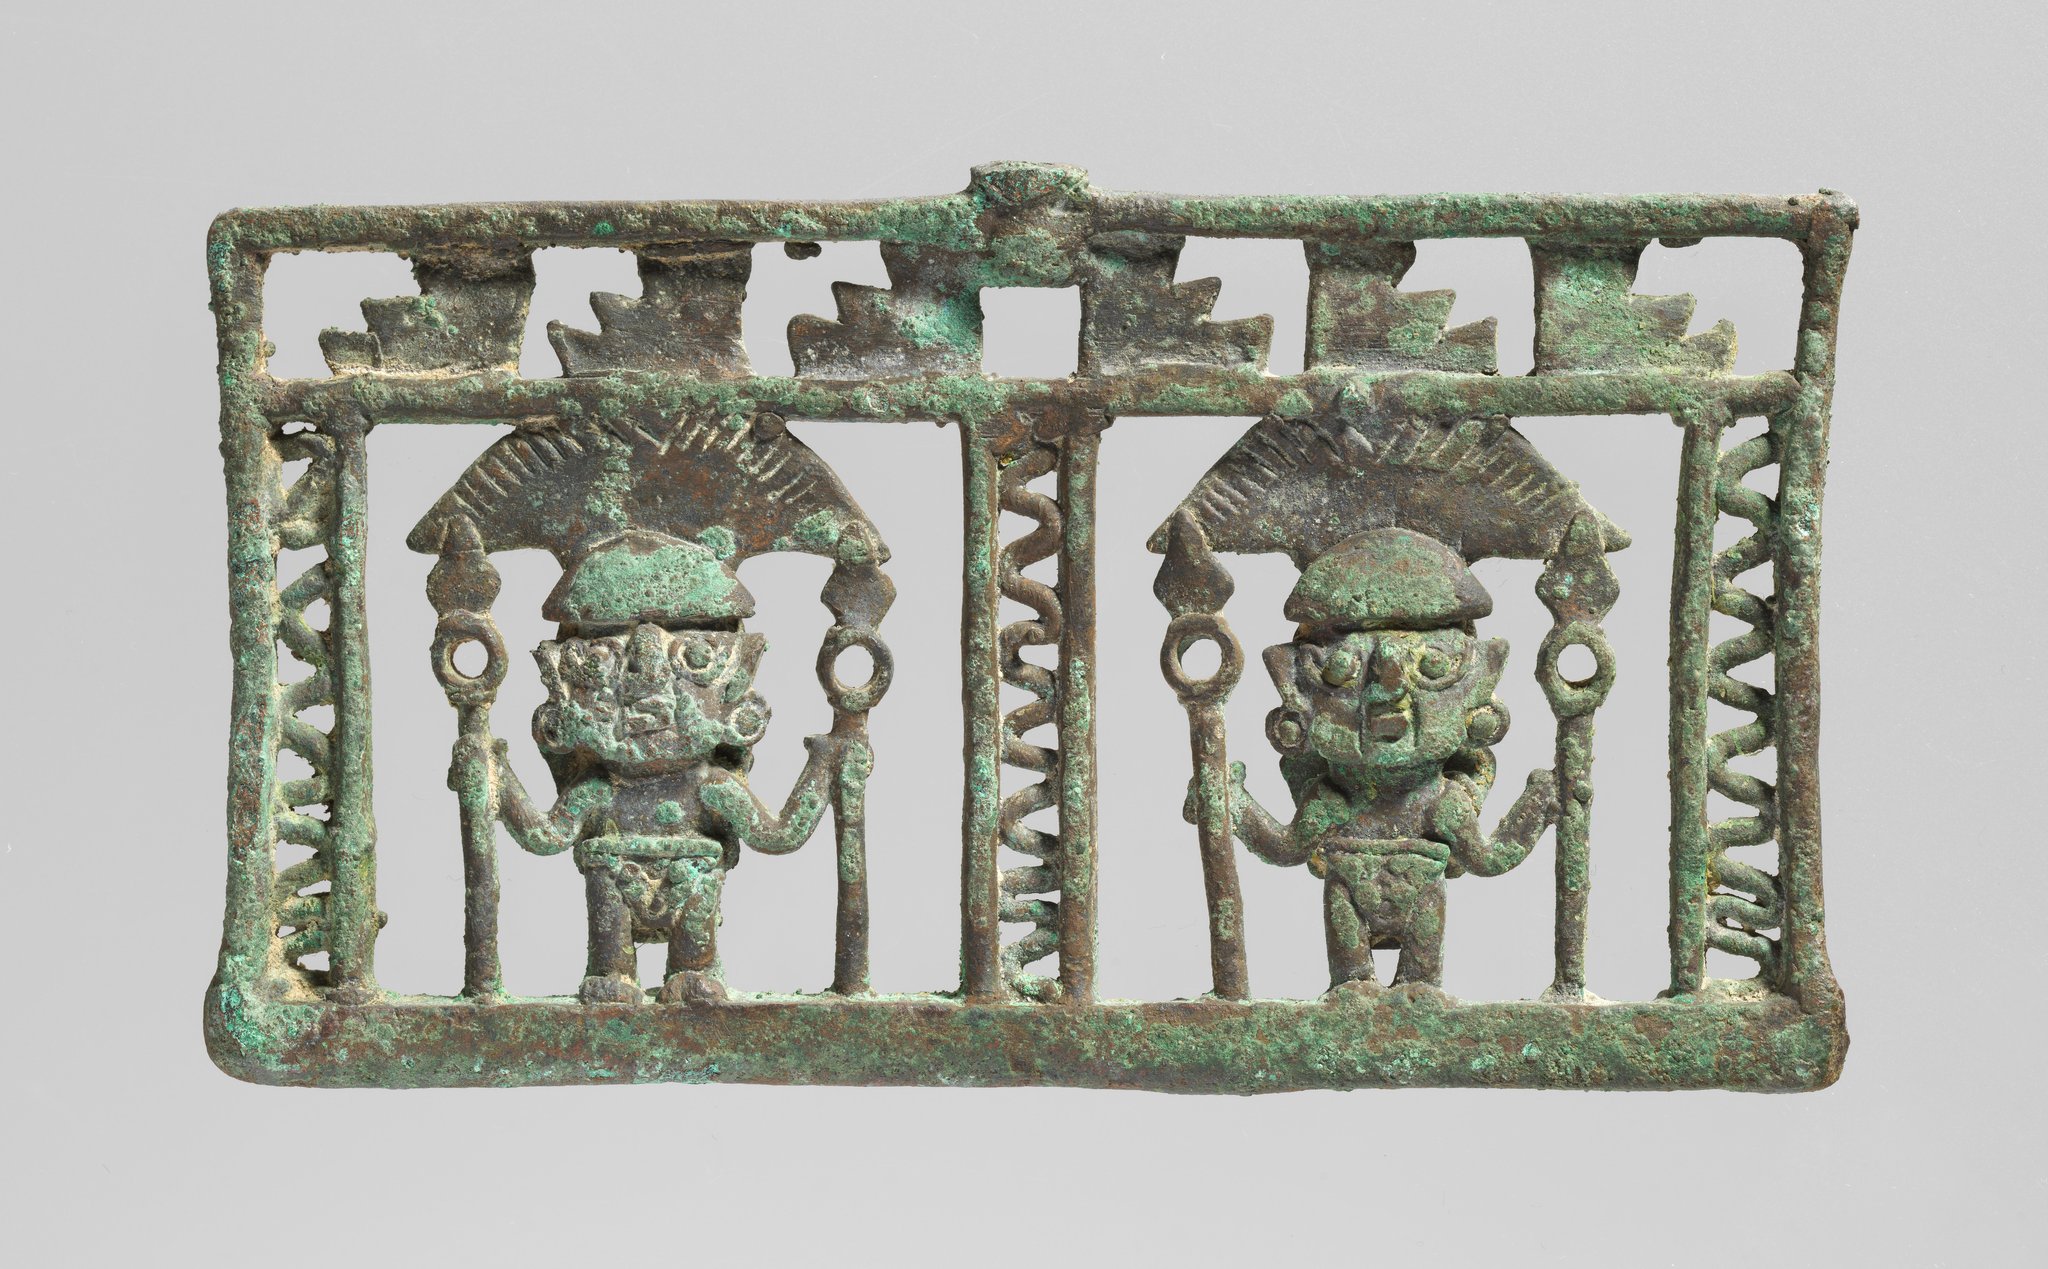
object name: scale balance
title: Two Scale Balance Beams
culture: lambayeque, sicán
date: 801-1100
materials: copper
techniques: casting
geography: peru